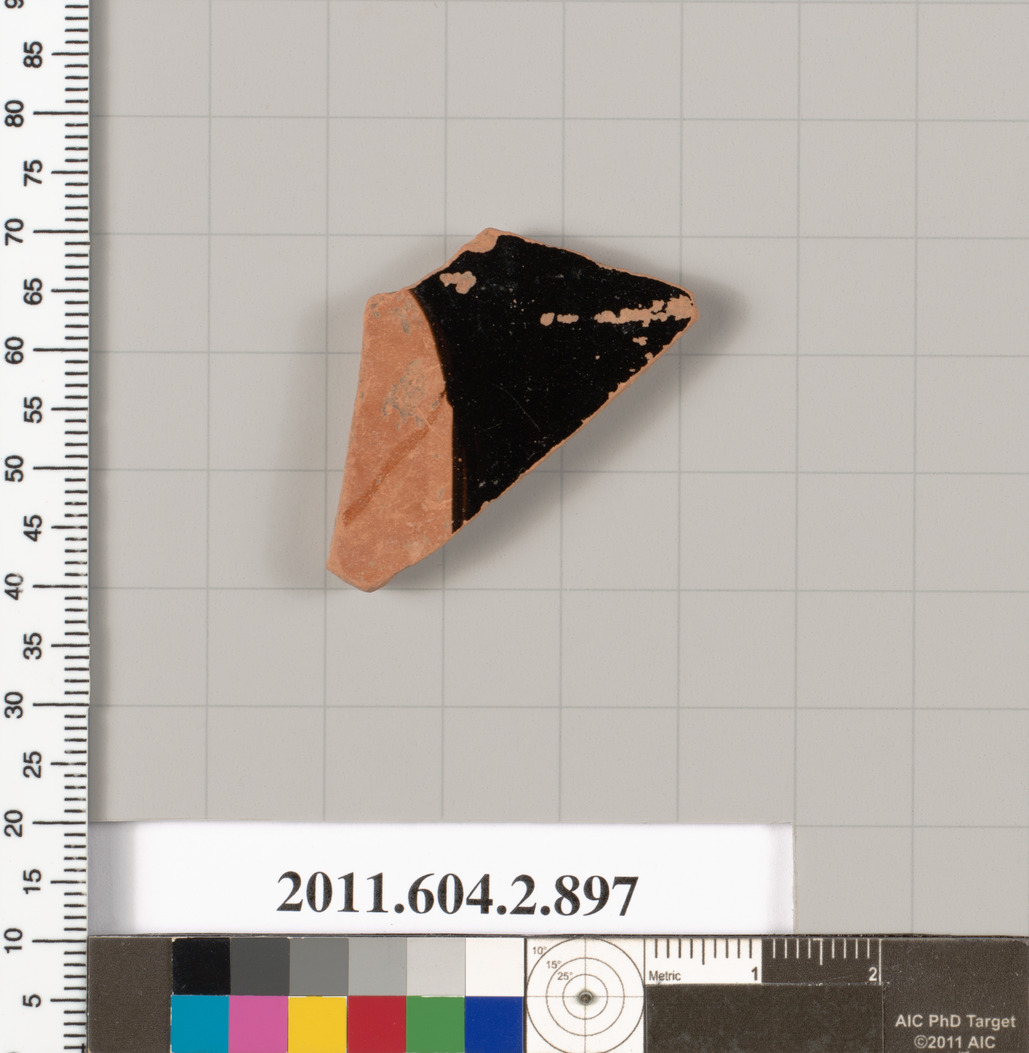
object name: bell krater fragment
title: Terracotta fragment of a bell-krater (bowl for mixing wine and water)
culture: greek, attic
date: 450-426 BCE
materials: terracotta